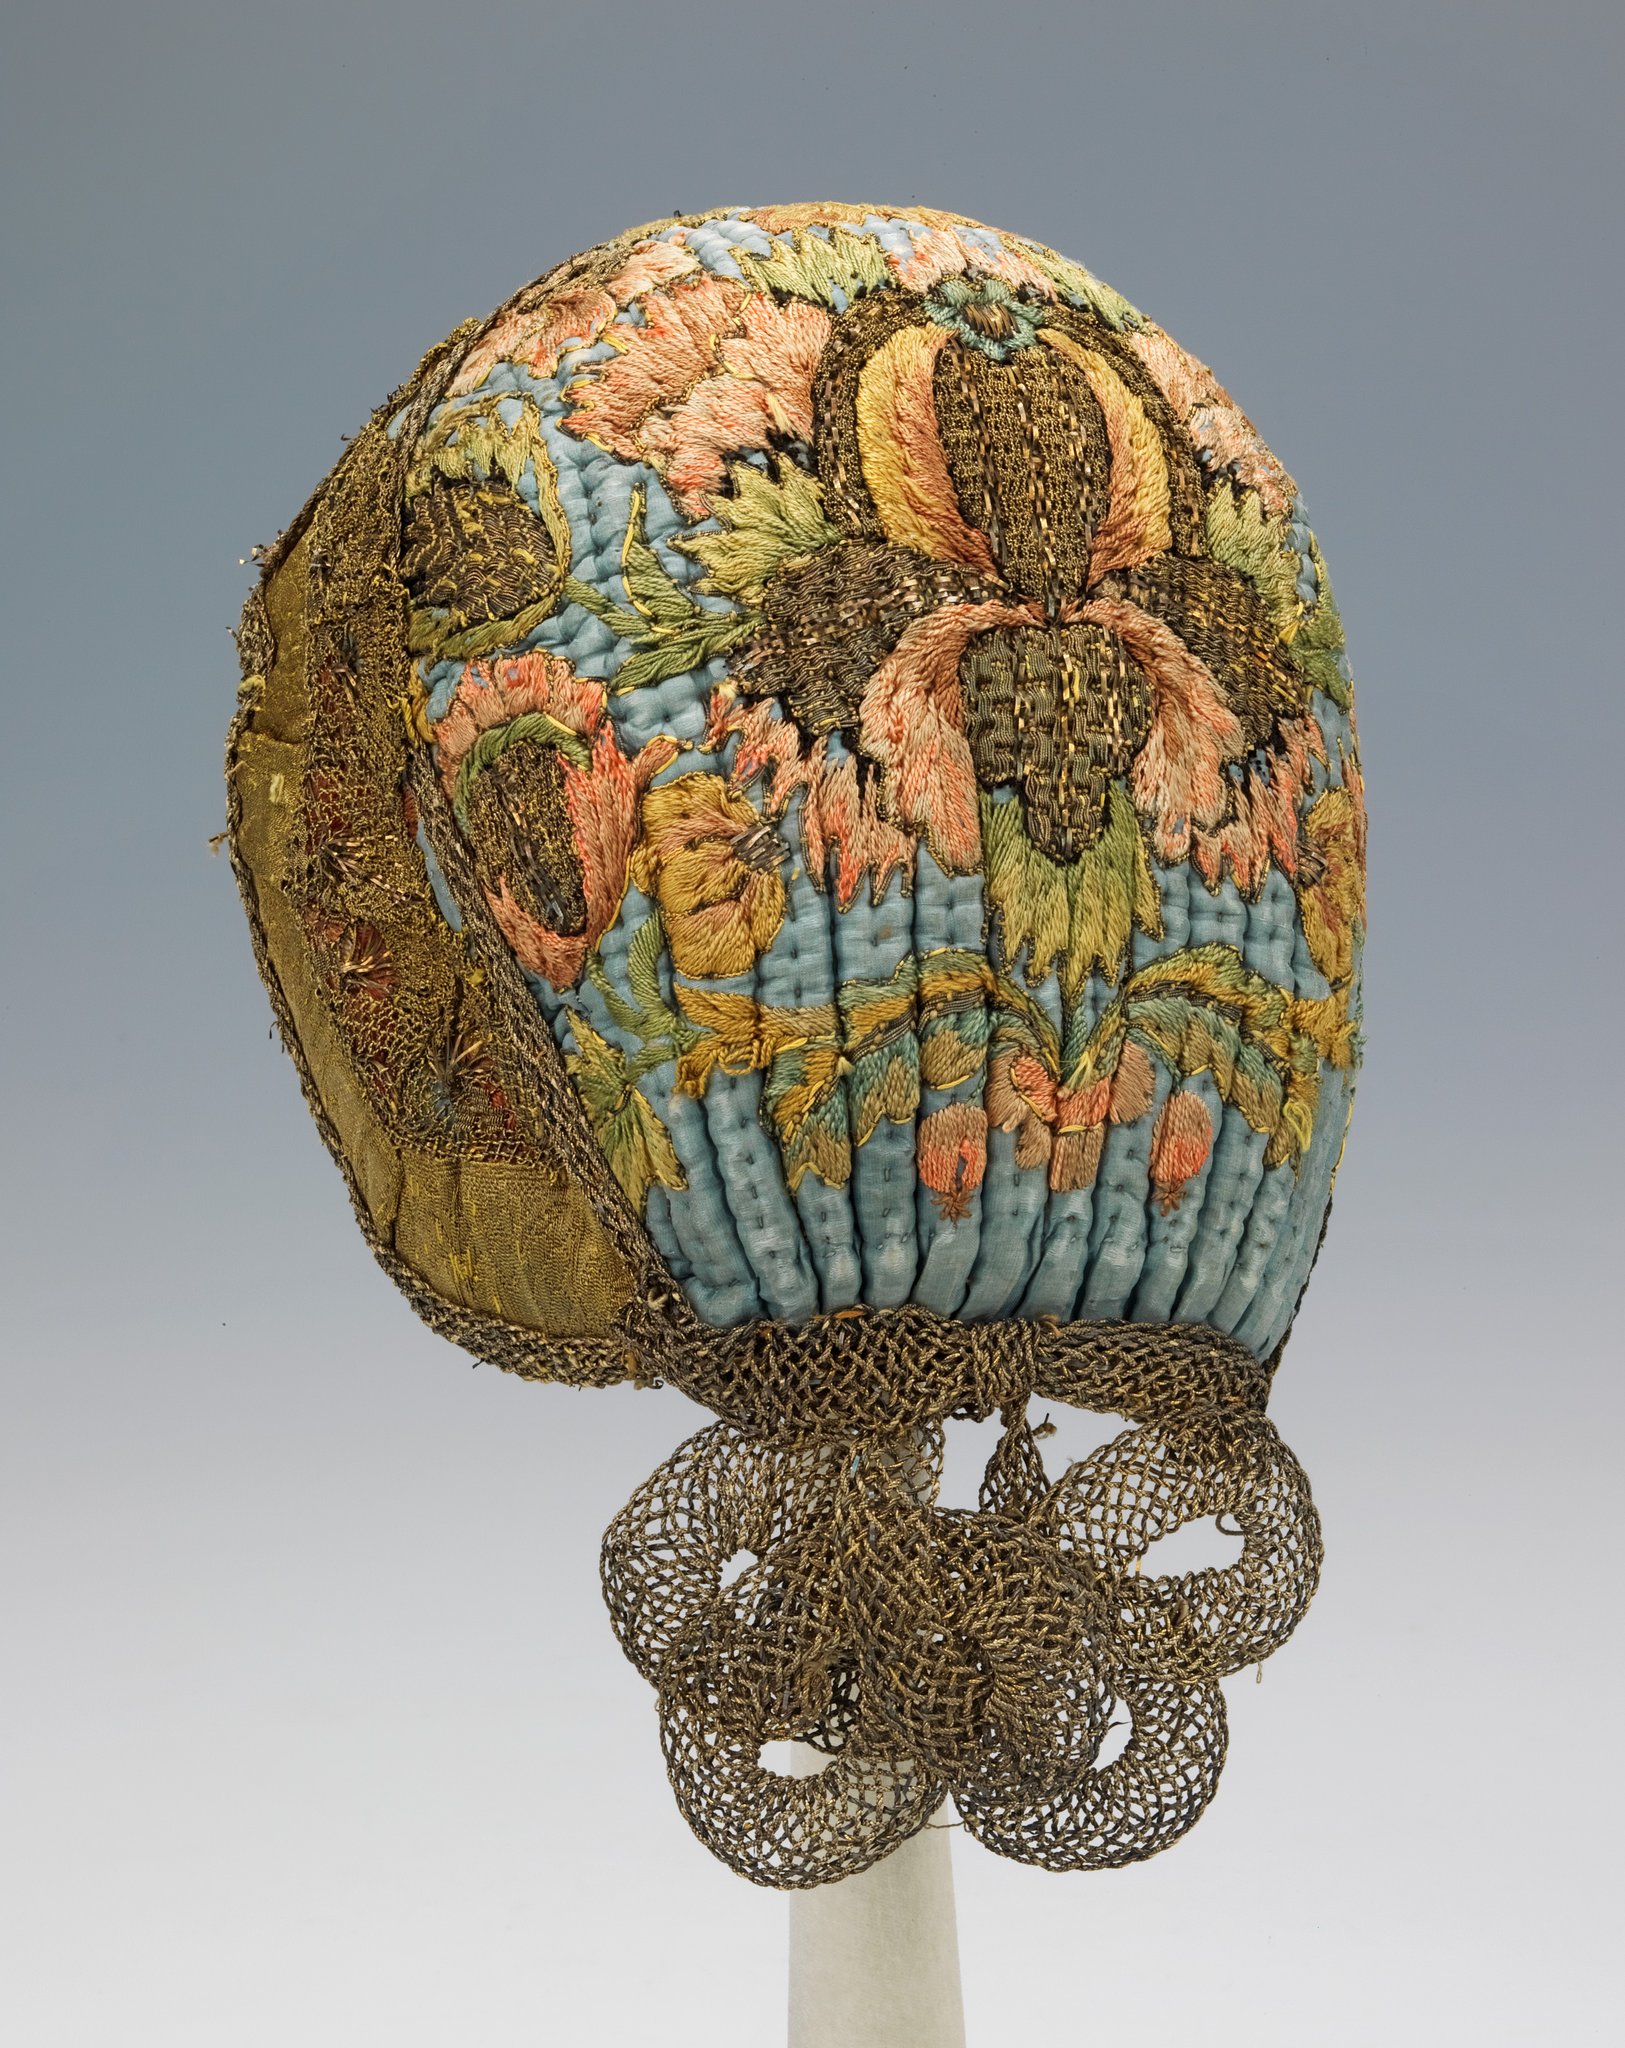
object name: cap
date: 1801-1833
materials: metal, silk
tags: flowers